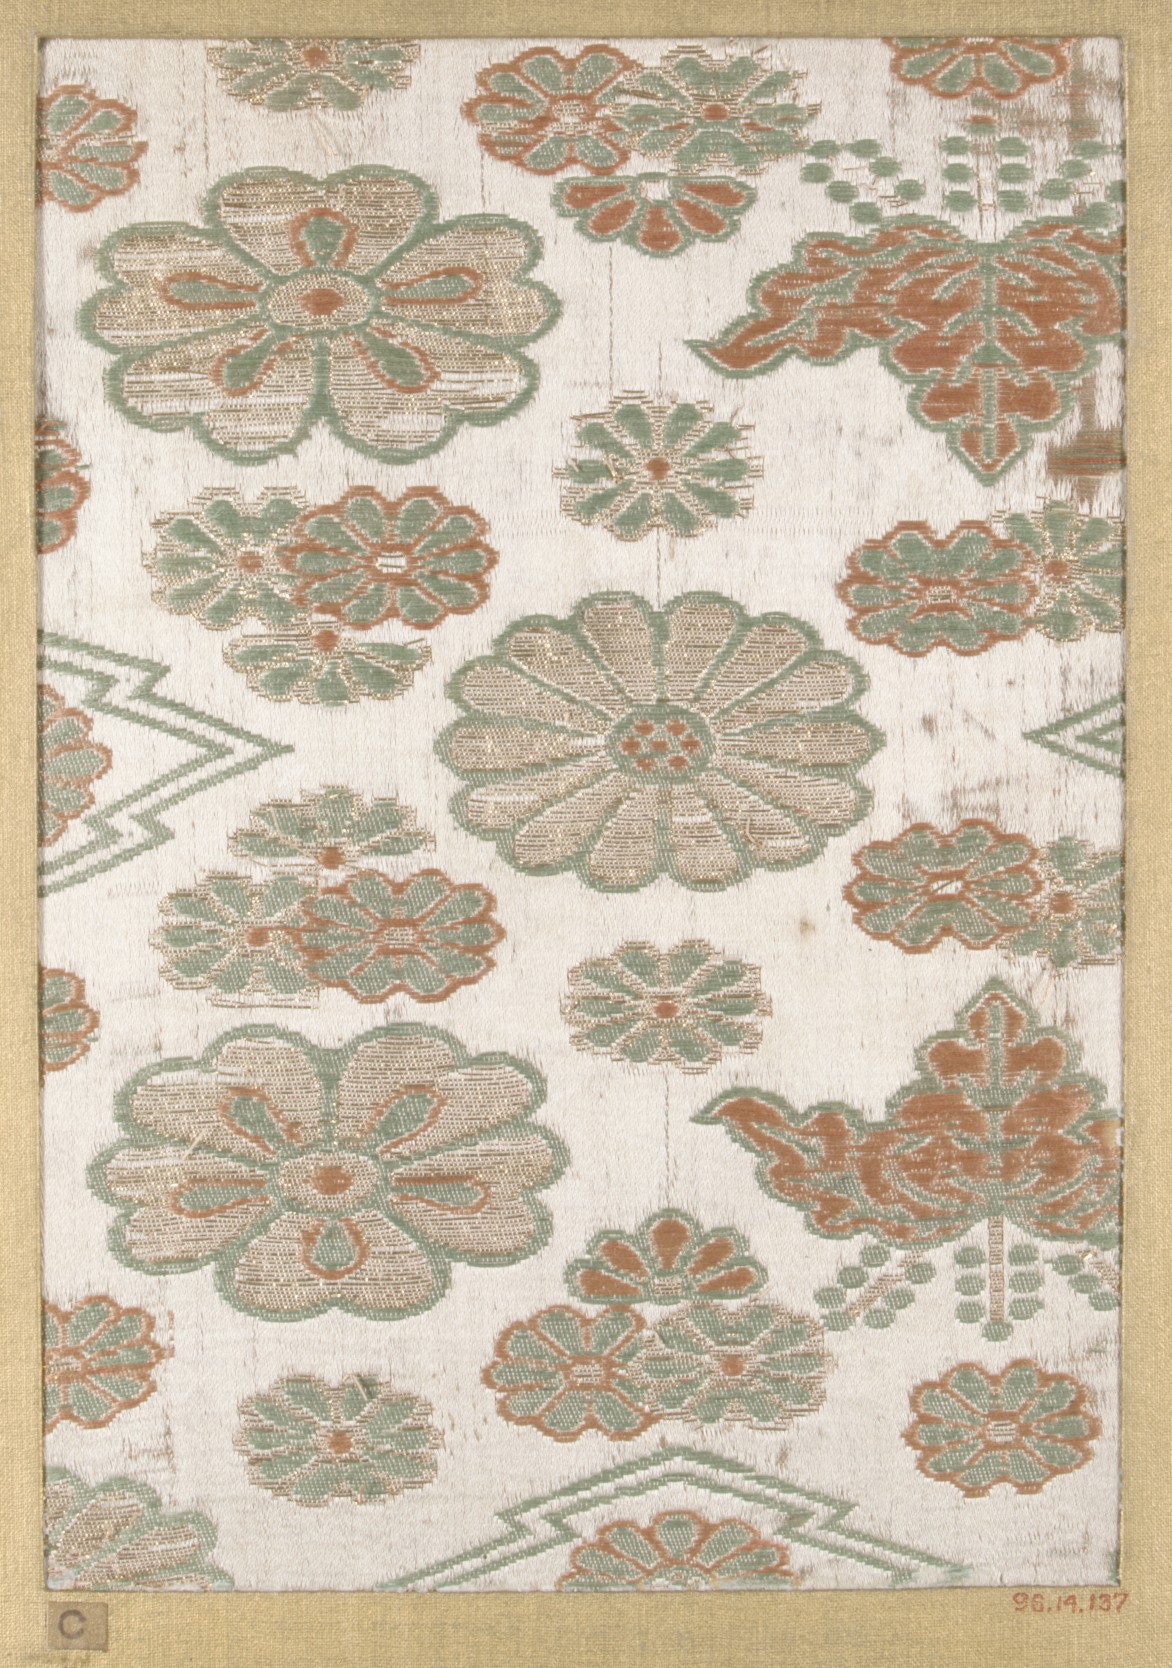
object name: piece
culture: japanese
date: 1701-1900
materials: silk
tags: flowers